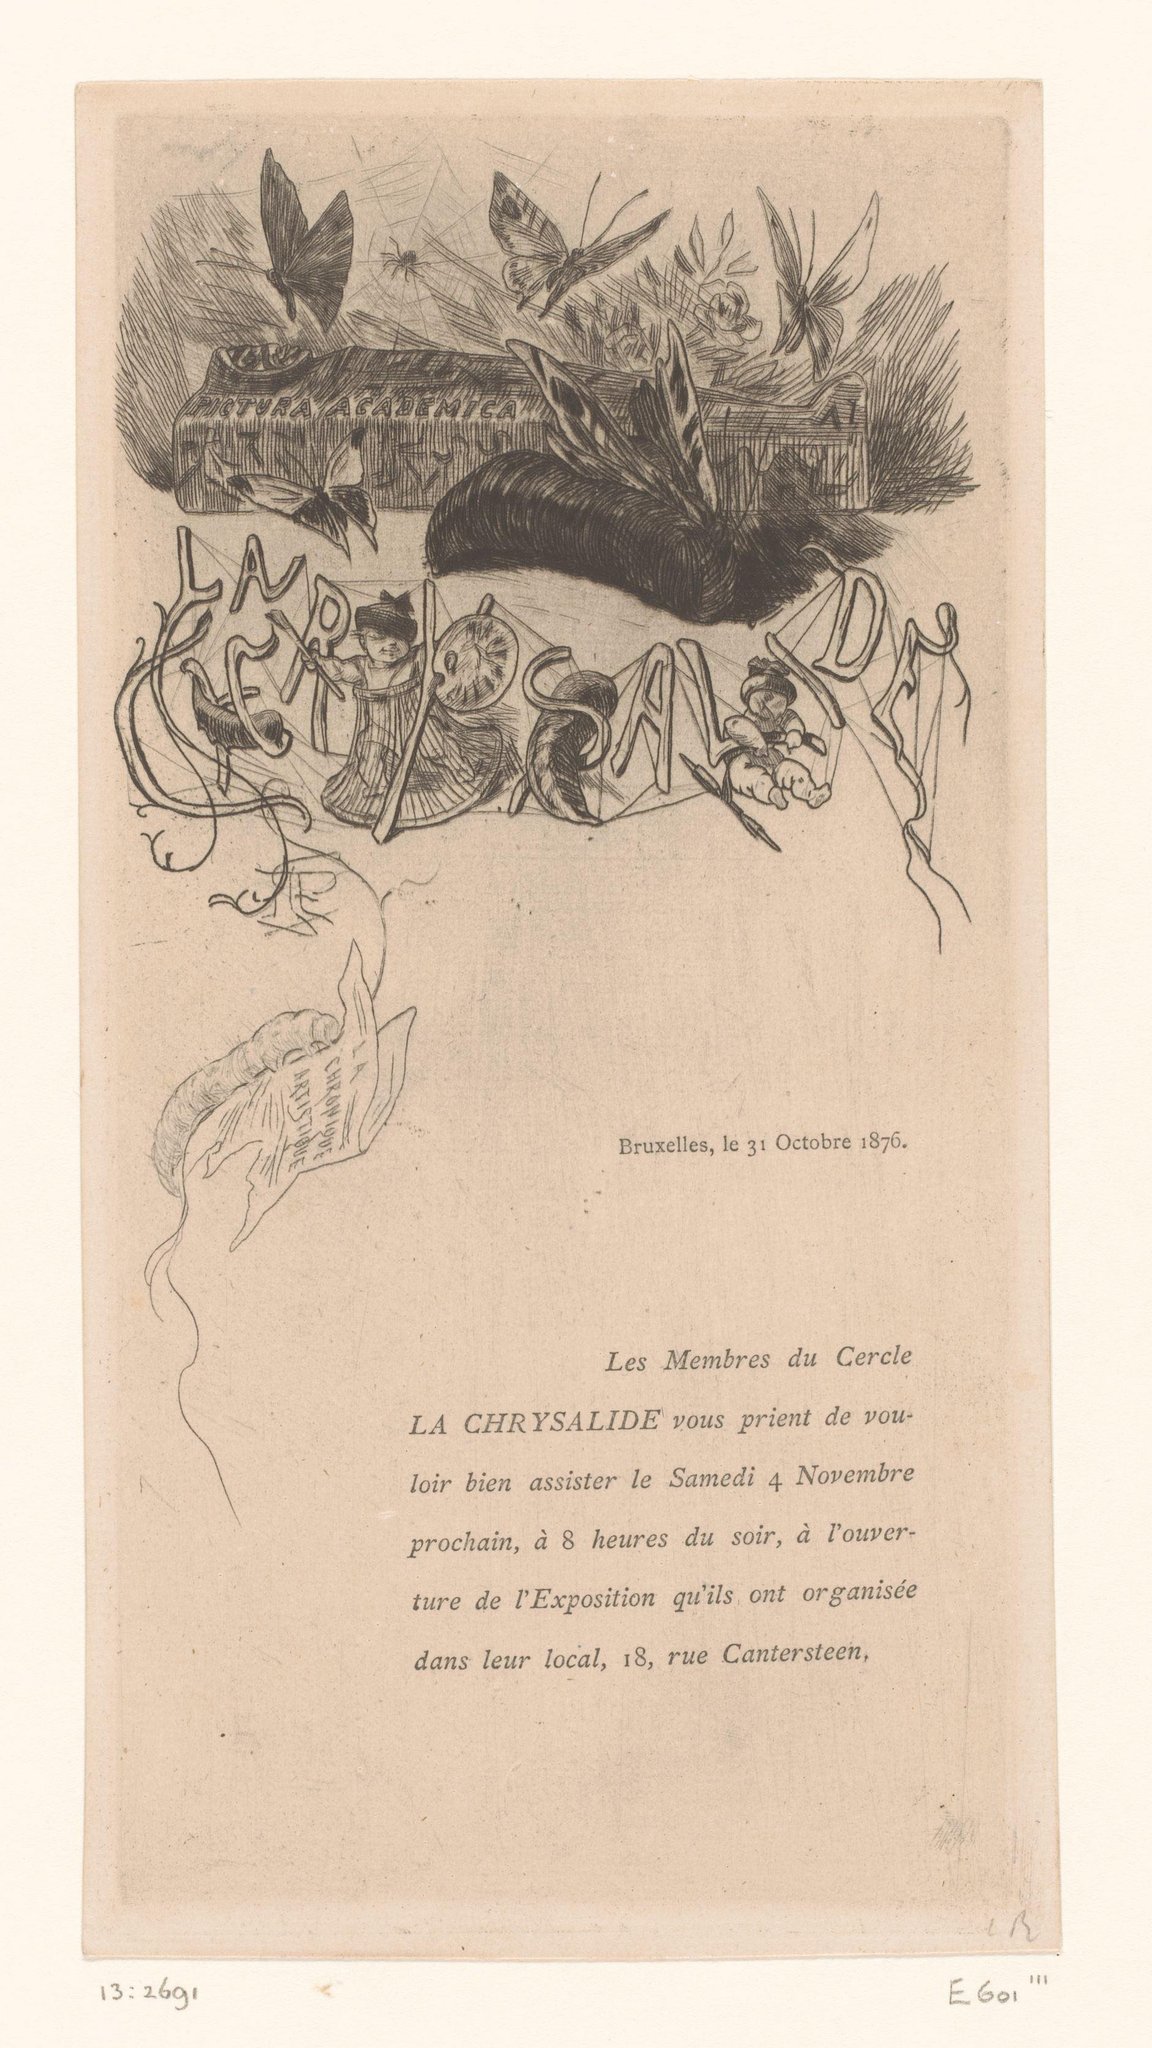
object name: print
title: Uitnodiging voor de tentoonstelling van kunstenaarskring La Chrysalide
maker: félicien rops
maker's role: draughtsman, print maker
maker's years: 1833-1898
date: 1876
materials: paper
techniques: drypoint, etching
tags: sarcophagus, insects: butterfly, silkworm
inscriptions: collector's mark: Lugt 2228